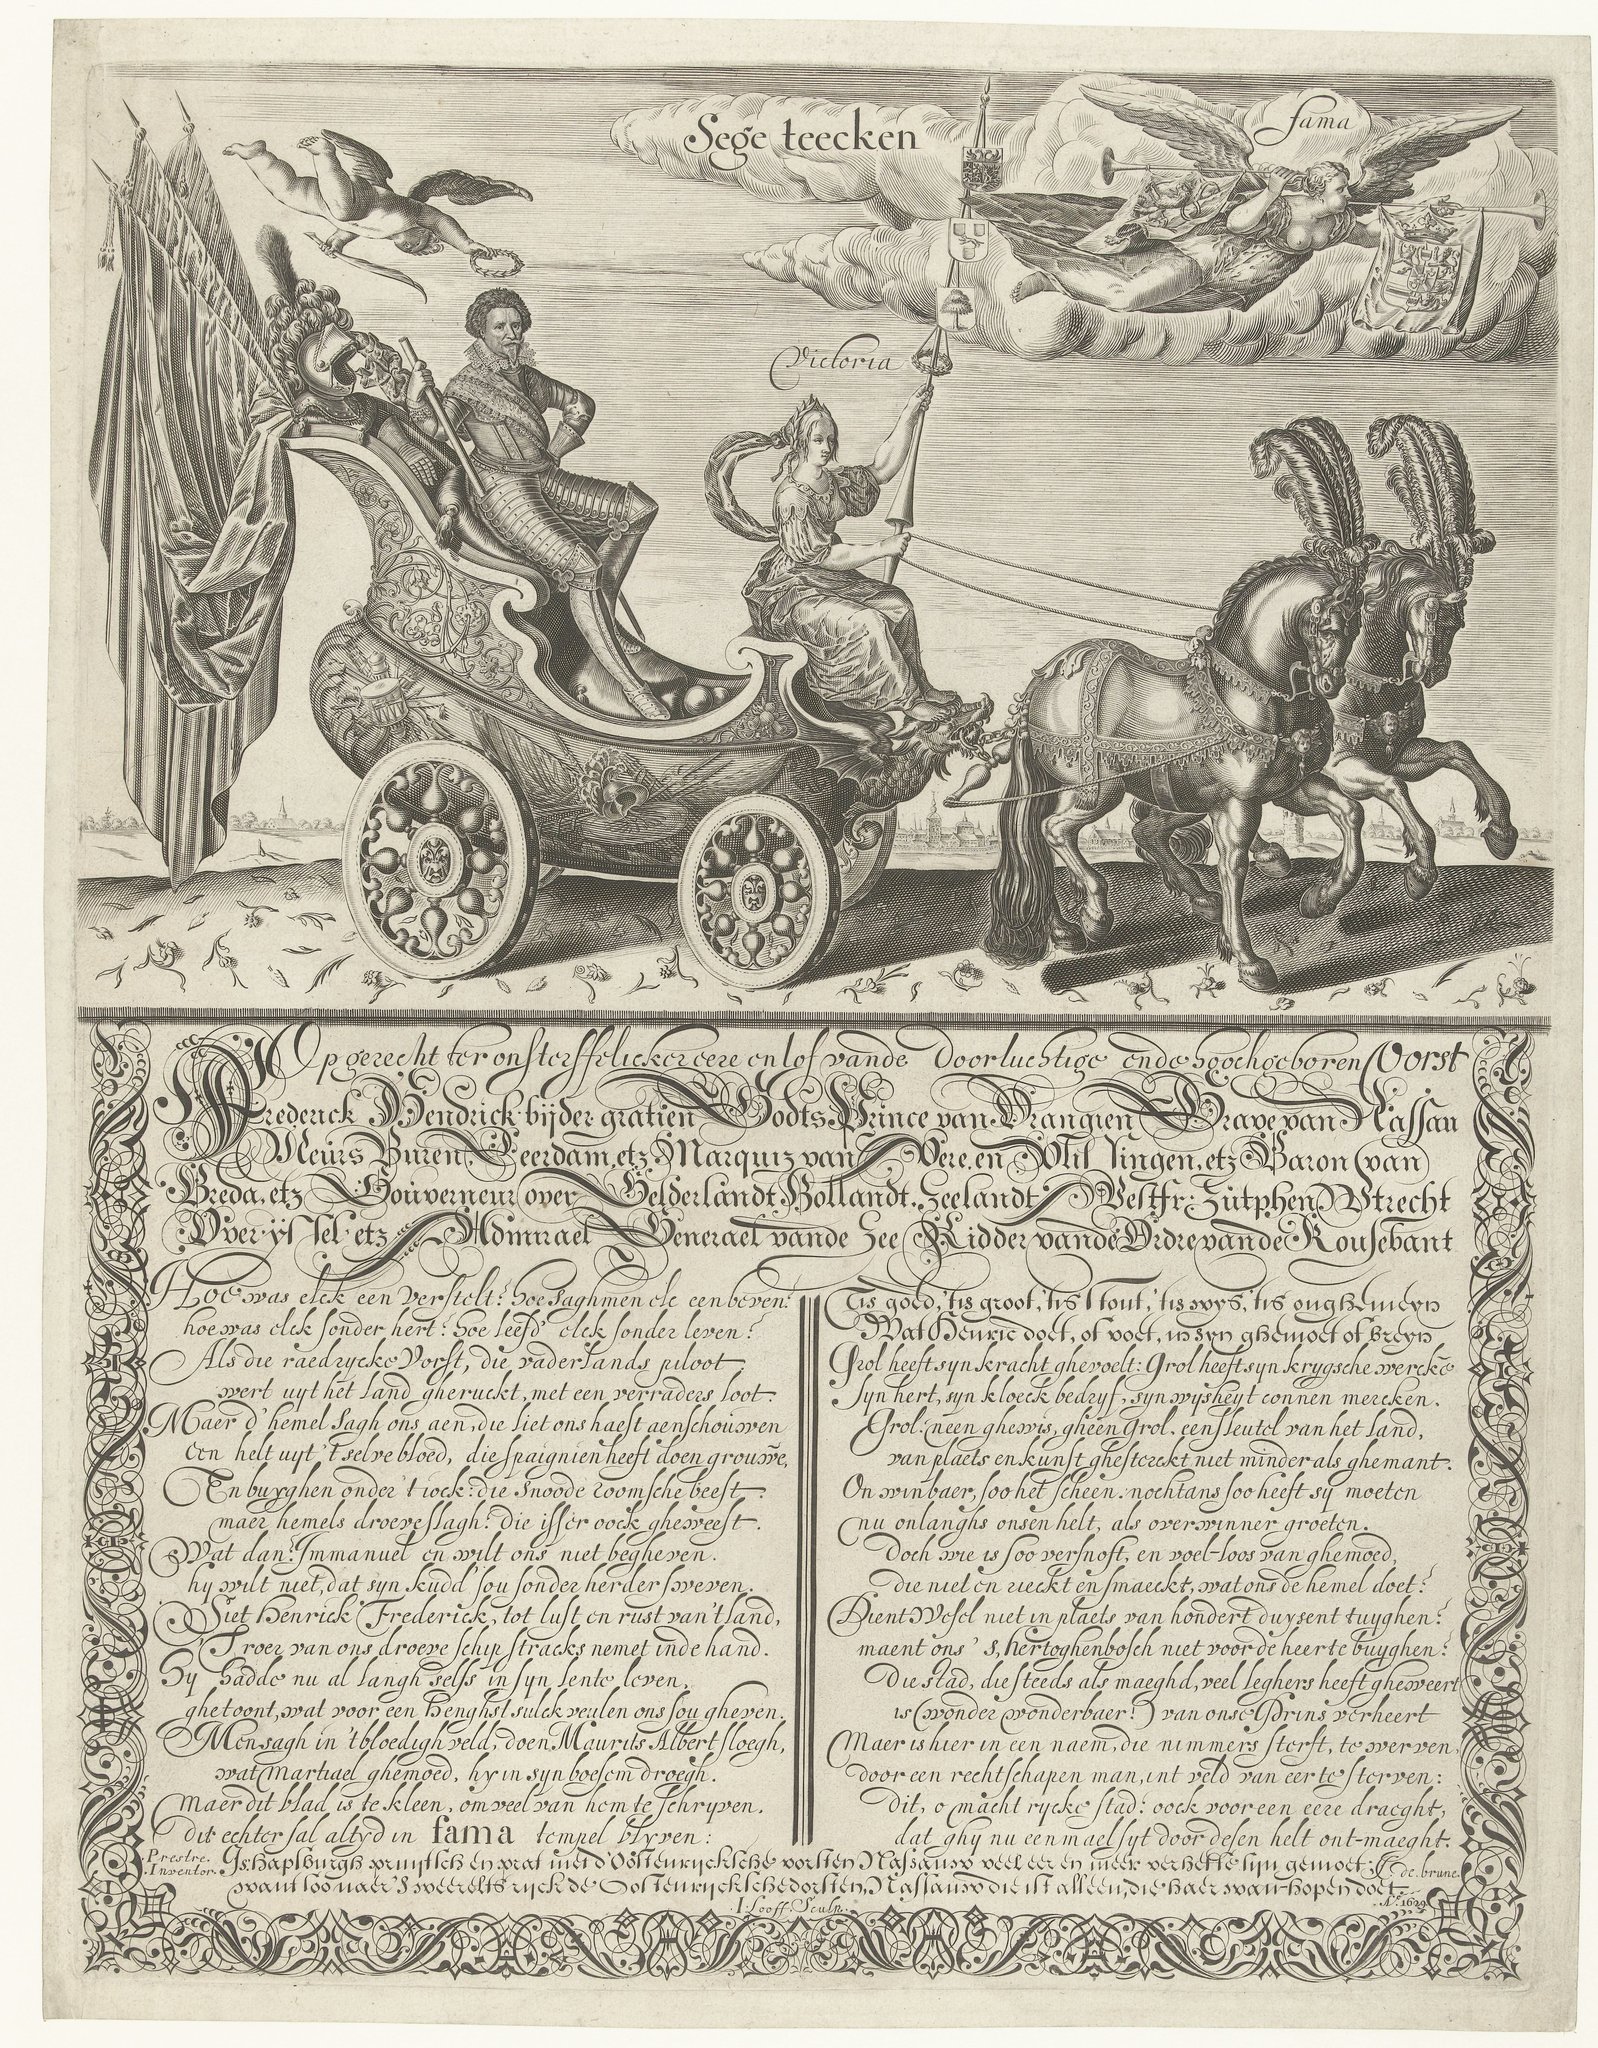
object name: print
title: Sege teecken Opgerecht ter onsterffelicker eere en lof vande doorluchtige ende hoochgeboren Vorst Frederick Hendrick (...)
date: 1629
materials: paper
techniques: engraving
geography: northern netherlands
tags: delft, the hague, frederick henry (prince of orange), symbolic triumphs of individual persons, 'victoria'; 'vittoria', 'vittoria navale', 'vittoria degl'antichi' (ripa), fame; 'fama', 'fama buona', 'fama chiara' (ripa)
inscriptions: date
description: Zegewagen voor Frederik Hendrik, 1629. De stadhouder in wapenrusting gezeten in een triomfkar gemend door de Overwinning (Victoria). In de lucht de Faam (Fama). Met een gekalligrafeerde tekst in 2 kolommen in het Nederlands onder de voorstelling.